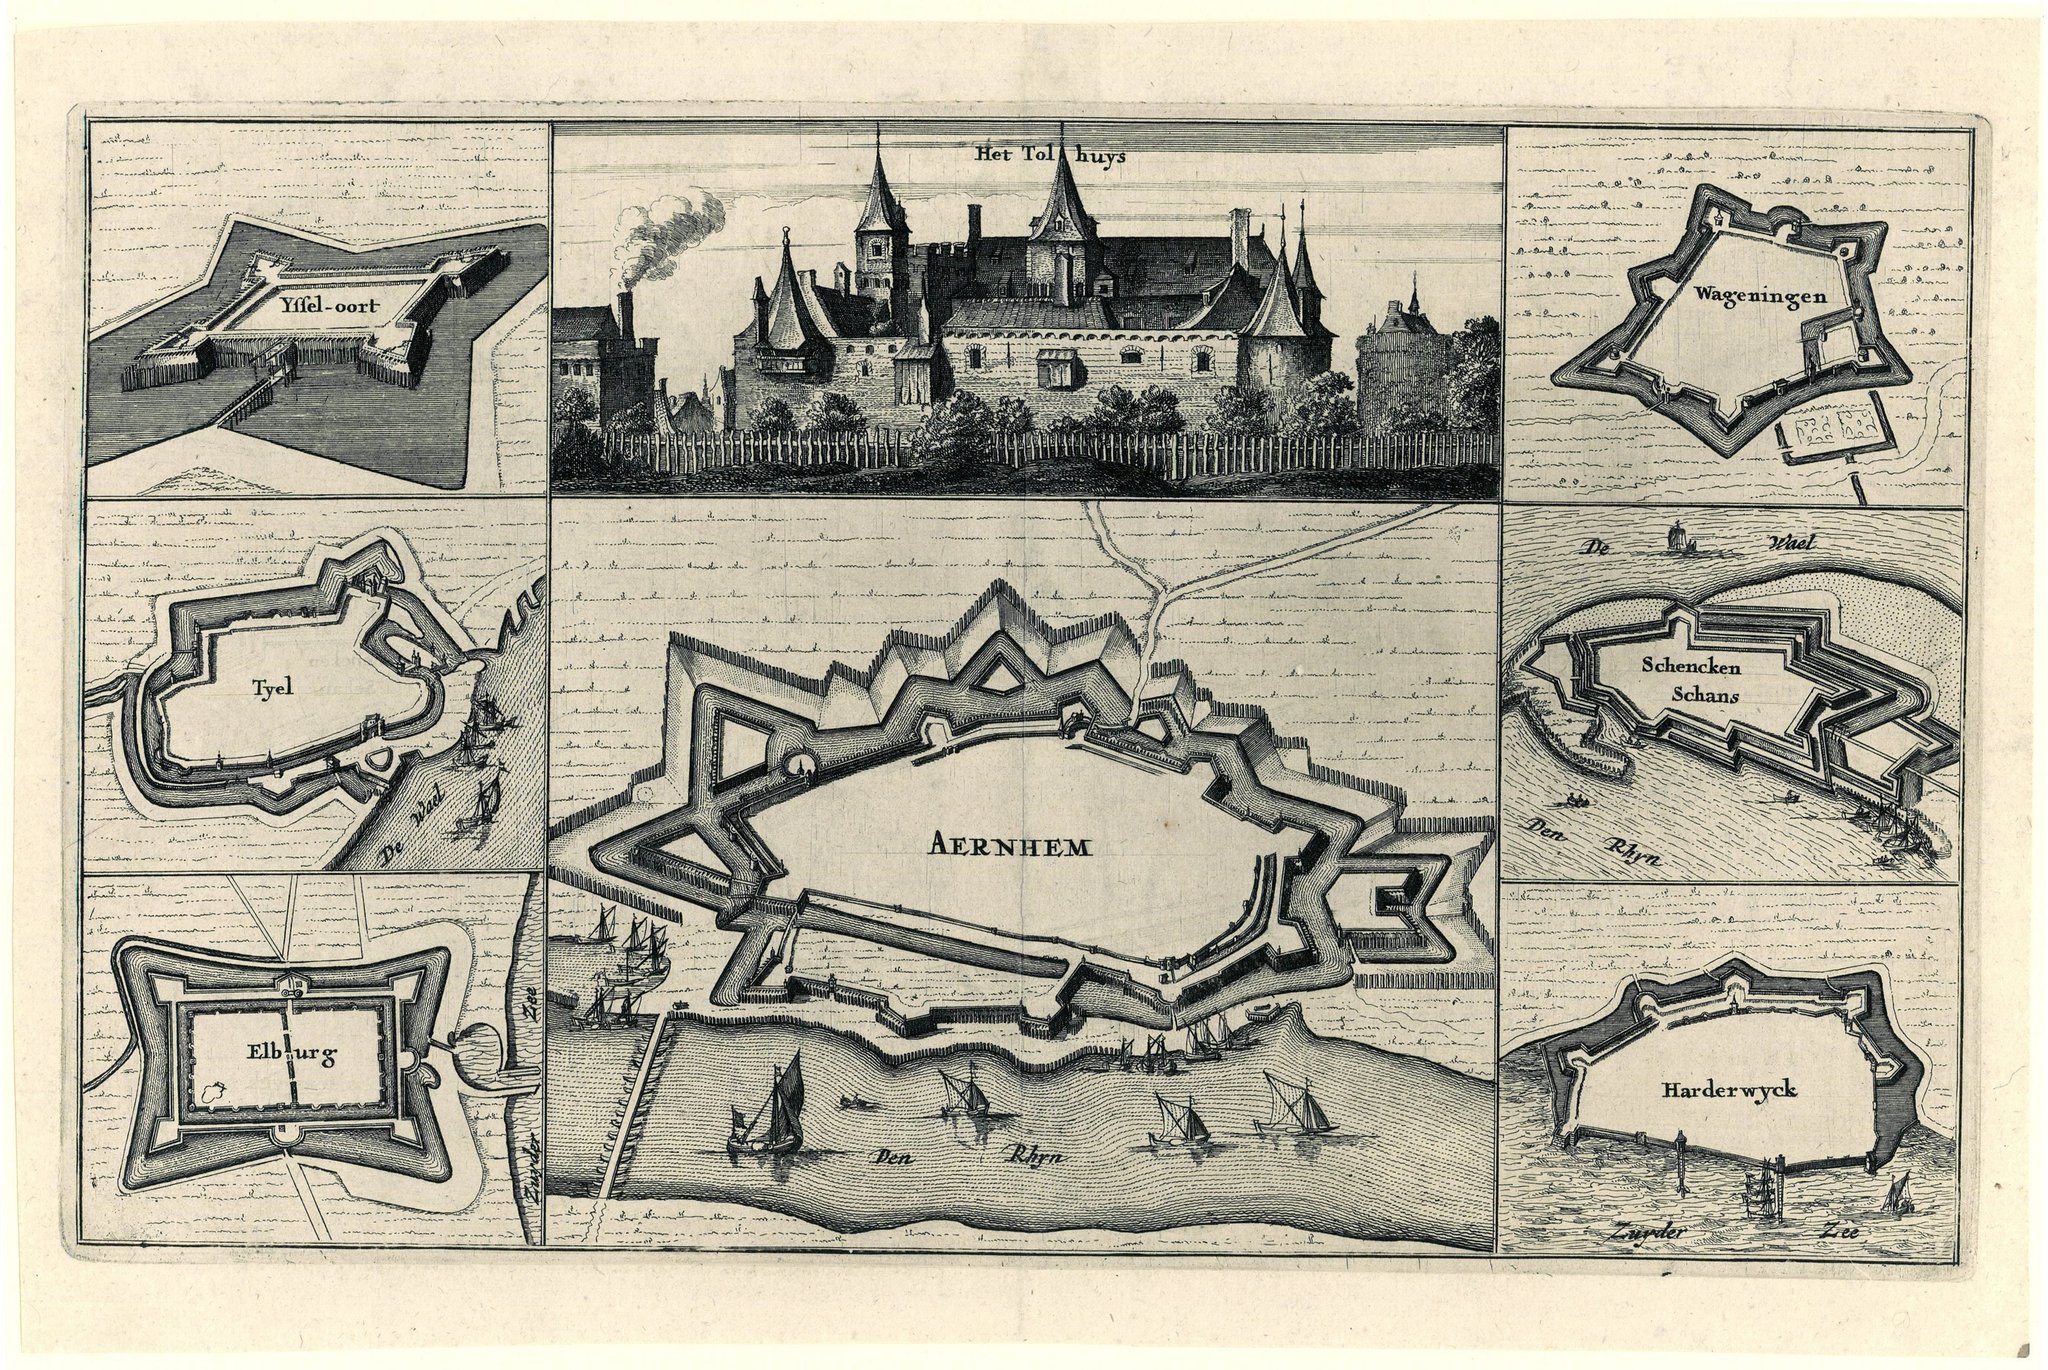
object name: map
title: Yssel-Oort / Tyel / Elburg / Het Tolhuys / Aernhem / Wageningen / Schenckenschans / Harderwyck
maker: Anonymous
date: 1675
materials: paper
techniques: etching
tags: maps of cities, arnhem, rampjaar (disaster year)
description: Zeven plattegronden van door de Fransen in 1672 ingenomen vestingen en een gezicht op Het Tolhuis, door de Fransen in 1672 platgebrand. Links de plattegronden van IJseloord, Tiel en Elburg. In het midden een gezicht op Het Tolhuis, bij Lobith, en een vestingplattegrond van Arnhem. Rechts de plattegronden van Wageningen, Schenkenschans en Harderwijk.